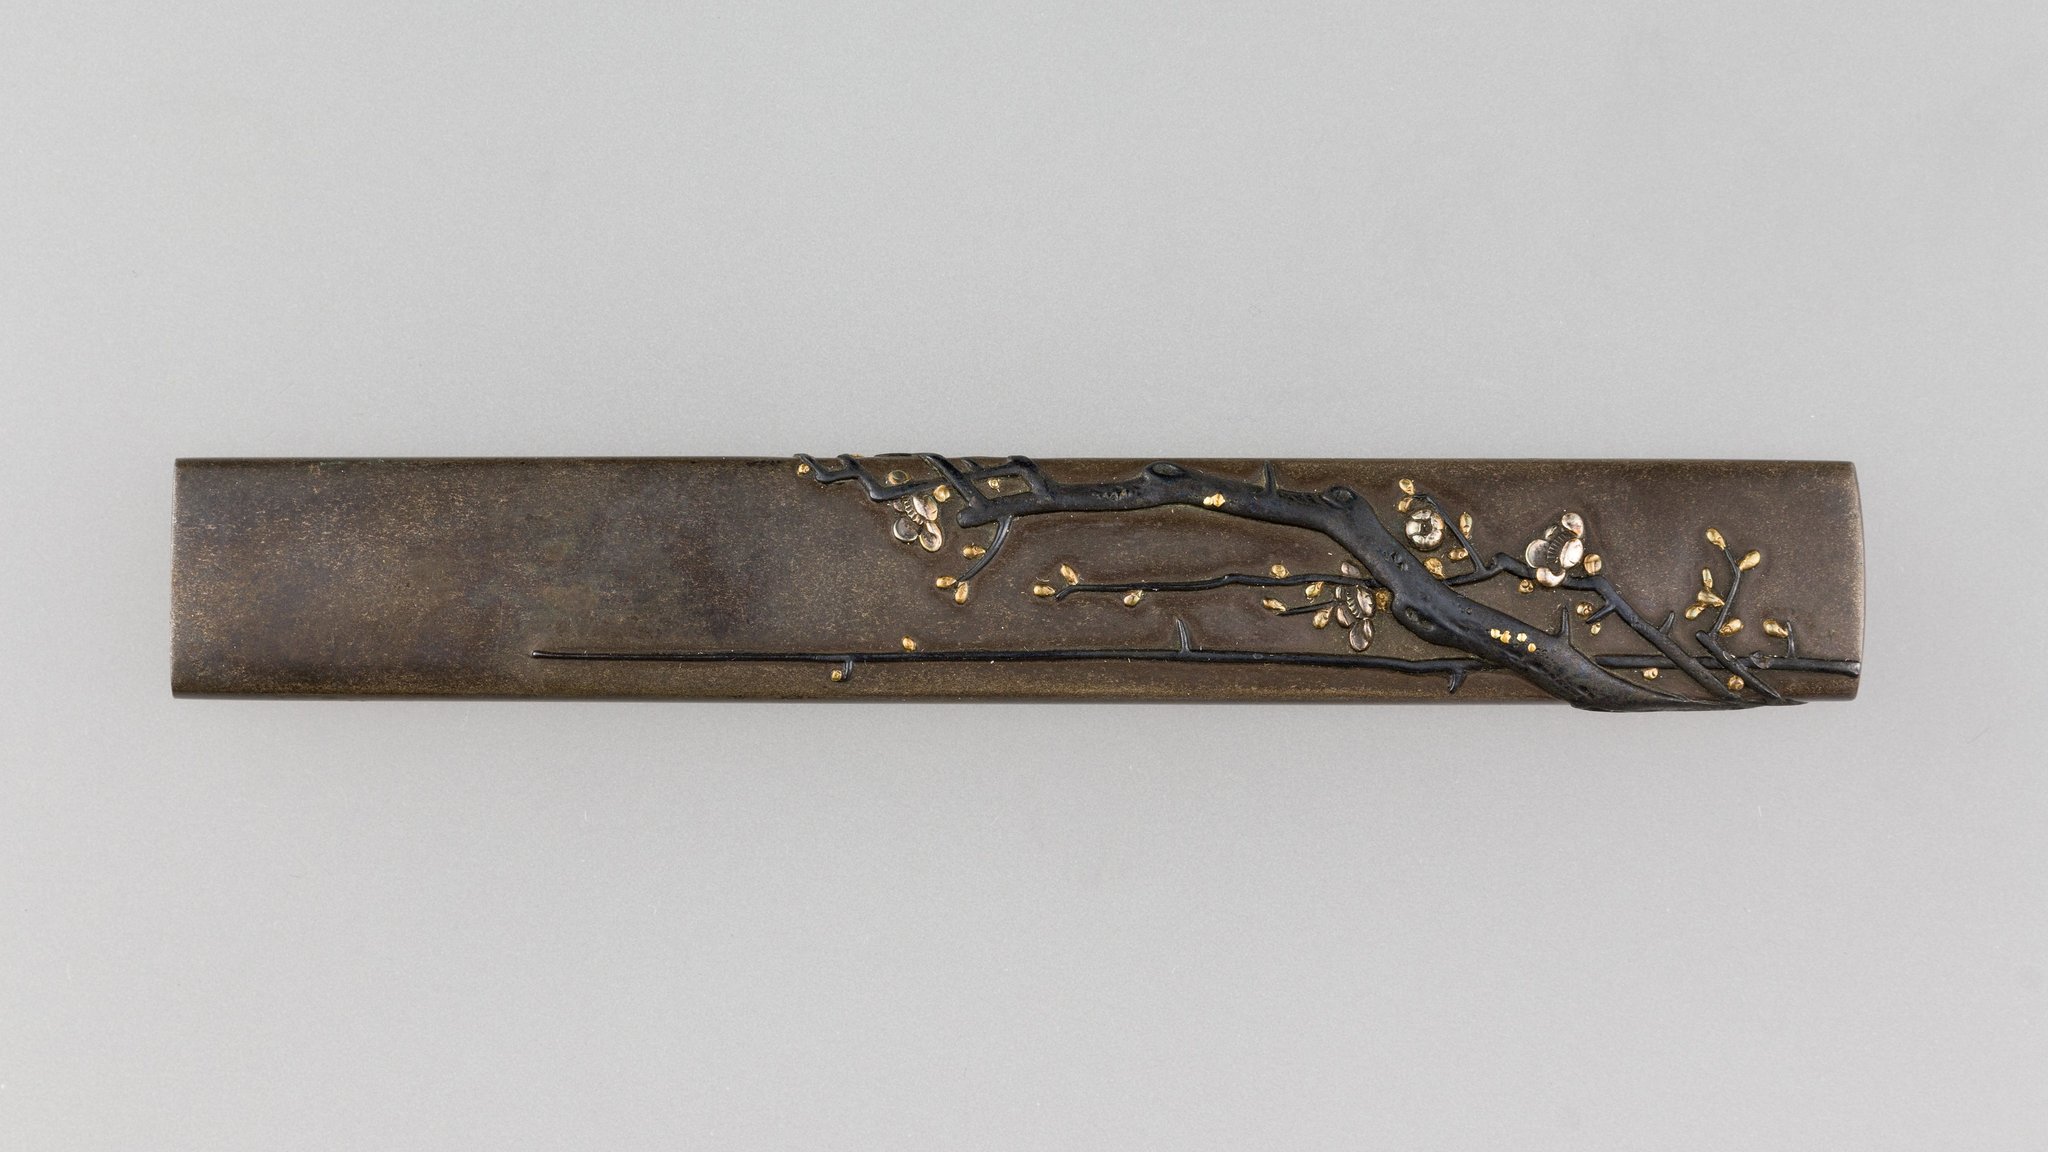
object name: knife handle kozuka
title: Knife Handle (Kozuka)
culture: japanese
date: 1800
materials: gold alloy, silver alloy, gold, silver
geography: japan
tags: trees